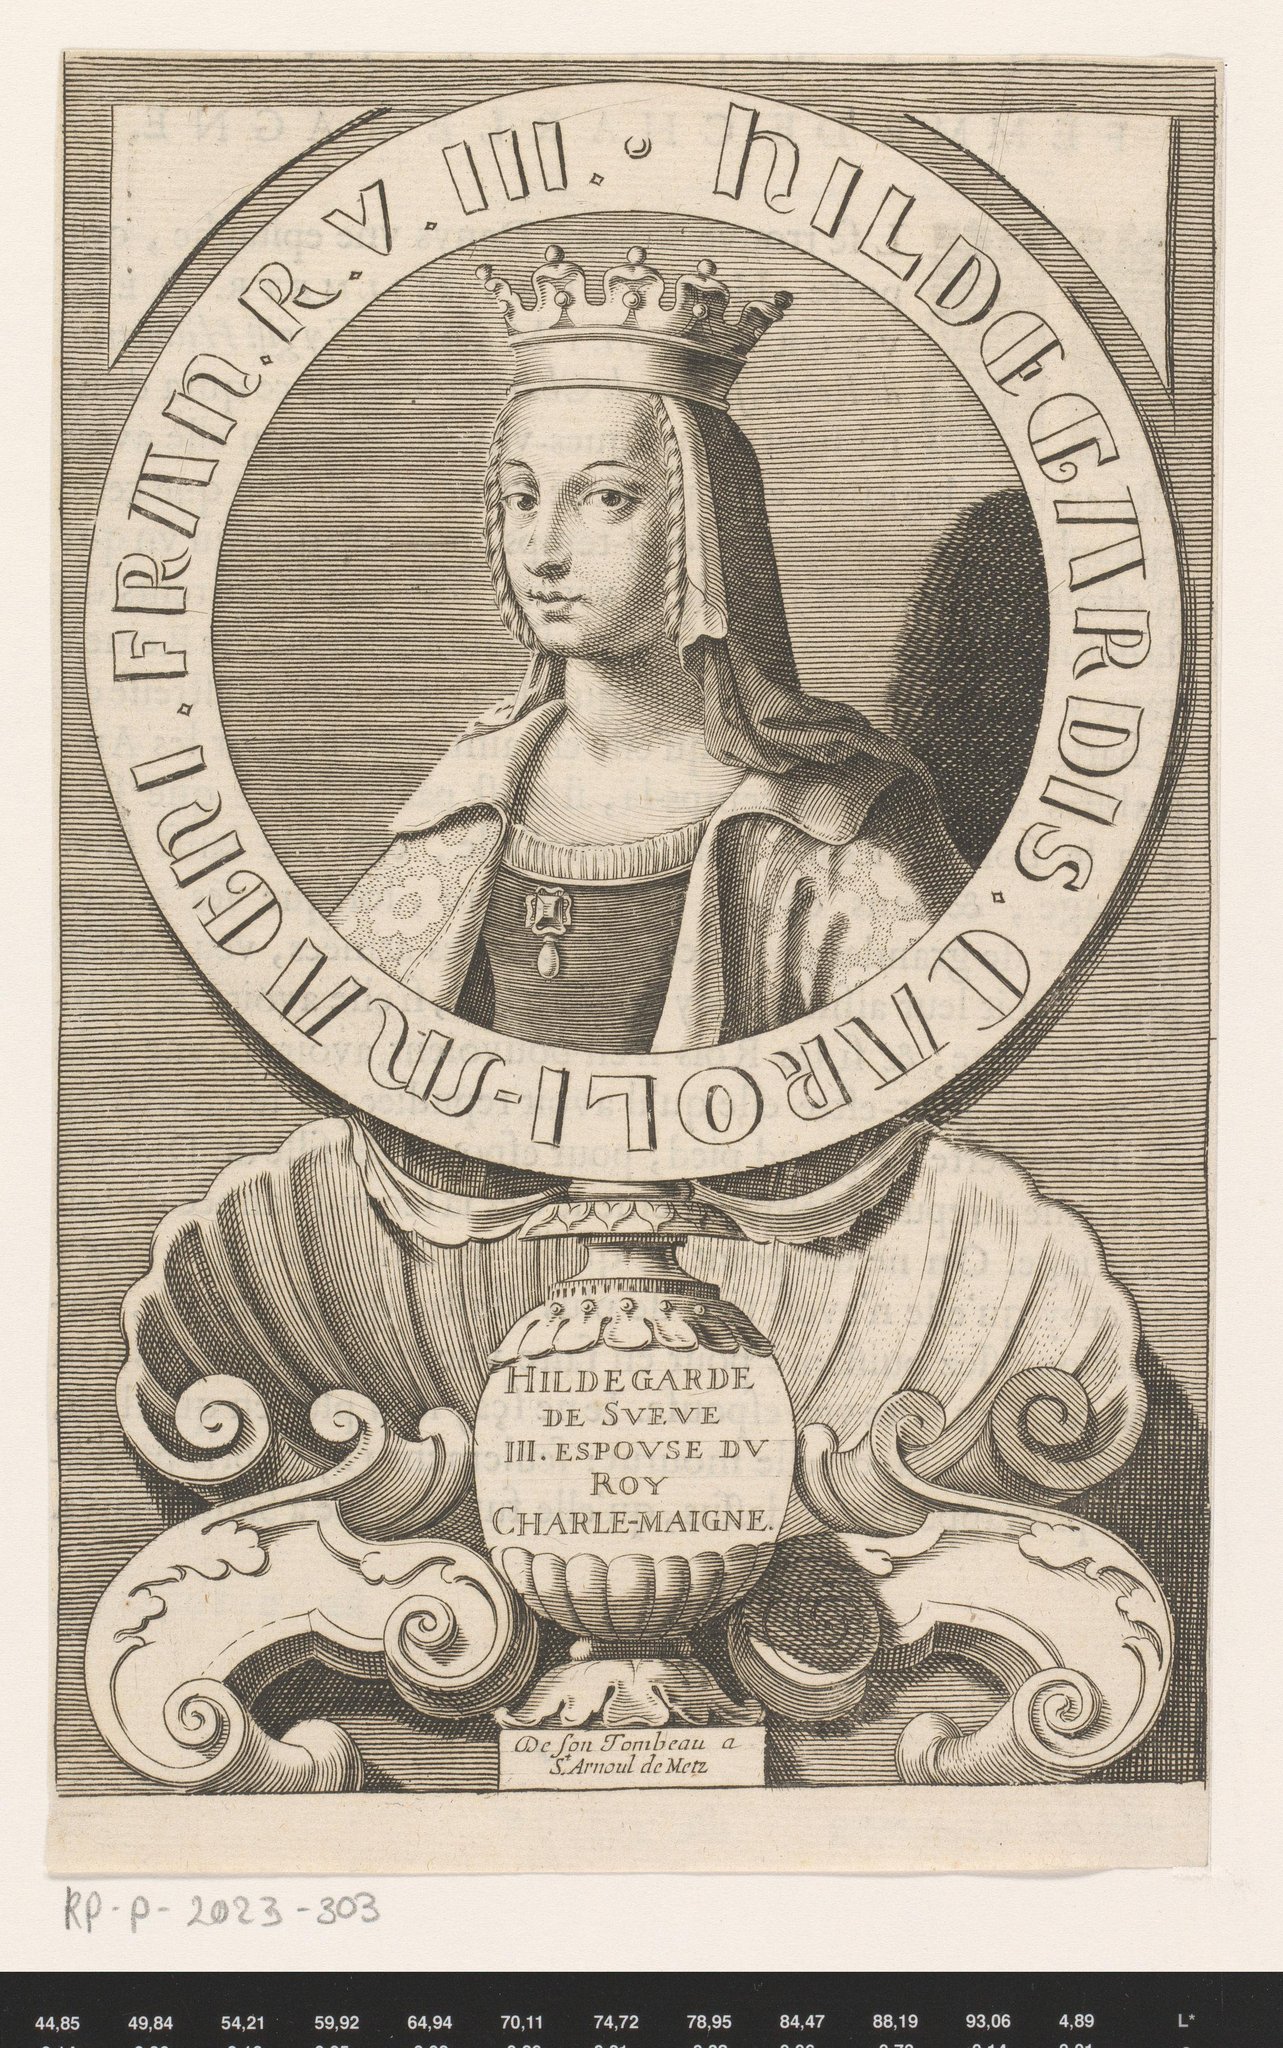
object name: book illustration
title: Portret van Hildegard, koningin der Franken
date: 1685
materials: paper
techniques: engraving, letterpress printing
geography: paris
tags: historical persons - bb - woman, king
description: Prent uit: Mézeray, François Eudes de. Histoire de France, depuis Faramond jusqu'au regne de Louis le Juste. (...) Parijs: Denis Thierry, Jean Guignard en Claude Barbin, 1685, dl. 1, p. 214